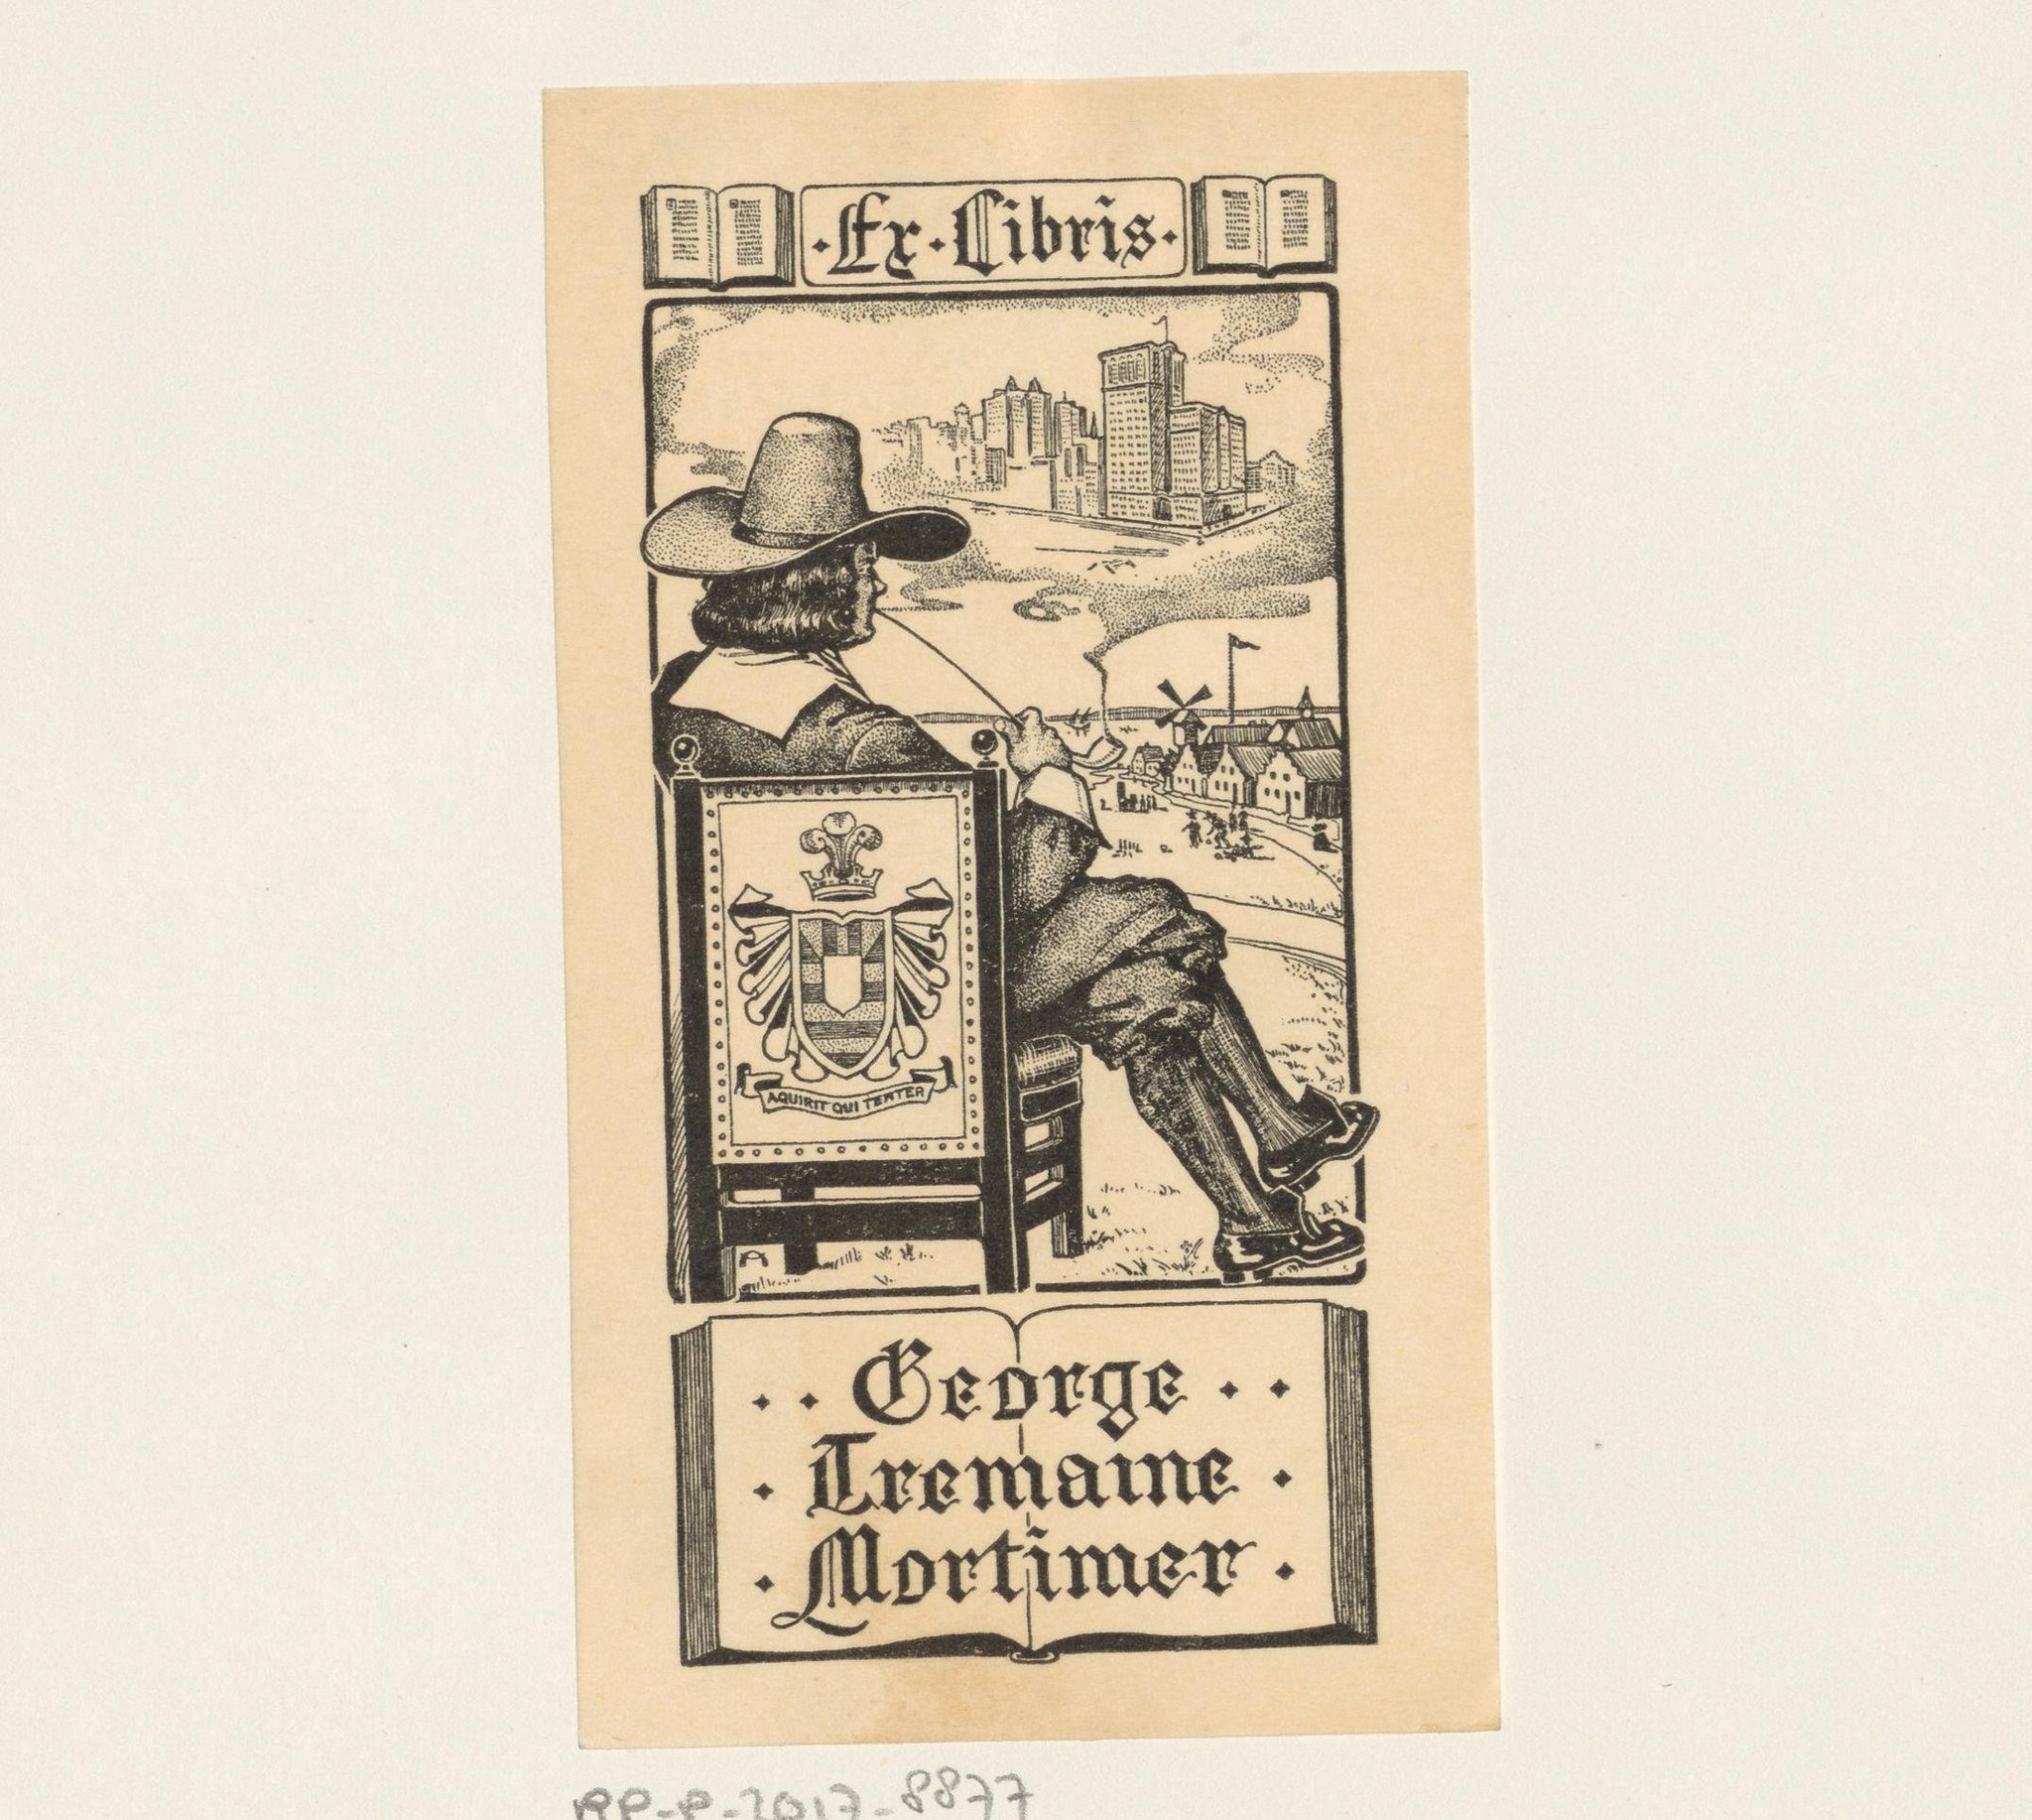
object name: bookplate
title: Ex libris van George Tremaine Mortimer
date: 1900-1999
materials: paper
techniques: printing block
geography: north and central america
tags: standing figure, historical costume, book, prospect of city, town panorama, silhouette of city, new york (city)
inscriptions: inscription: ‘A Dutchman looks at New york City and Nieu Amsterdam’, collector's mark: ‘Dr. S.X. Radbill/ 7043 Elmwood Ave./ Phila., Pa.’